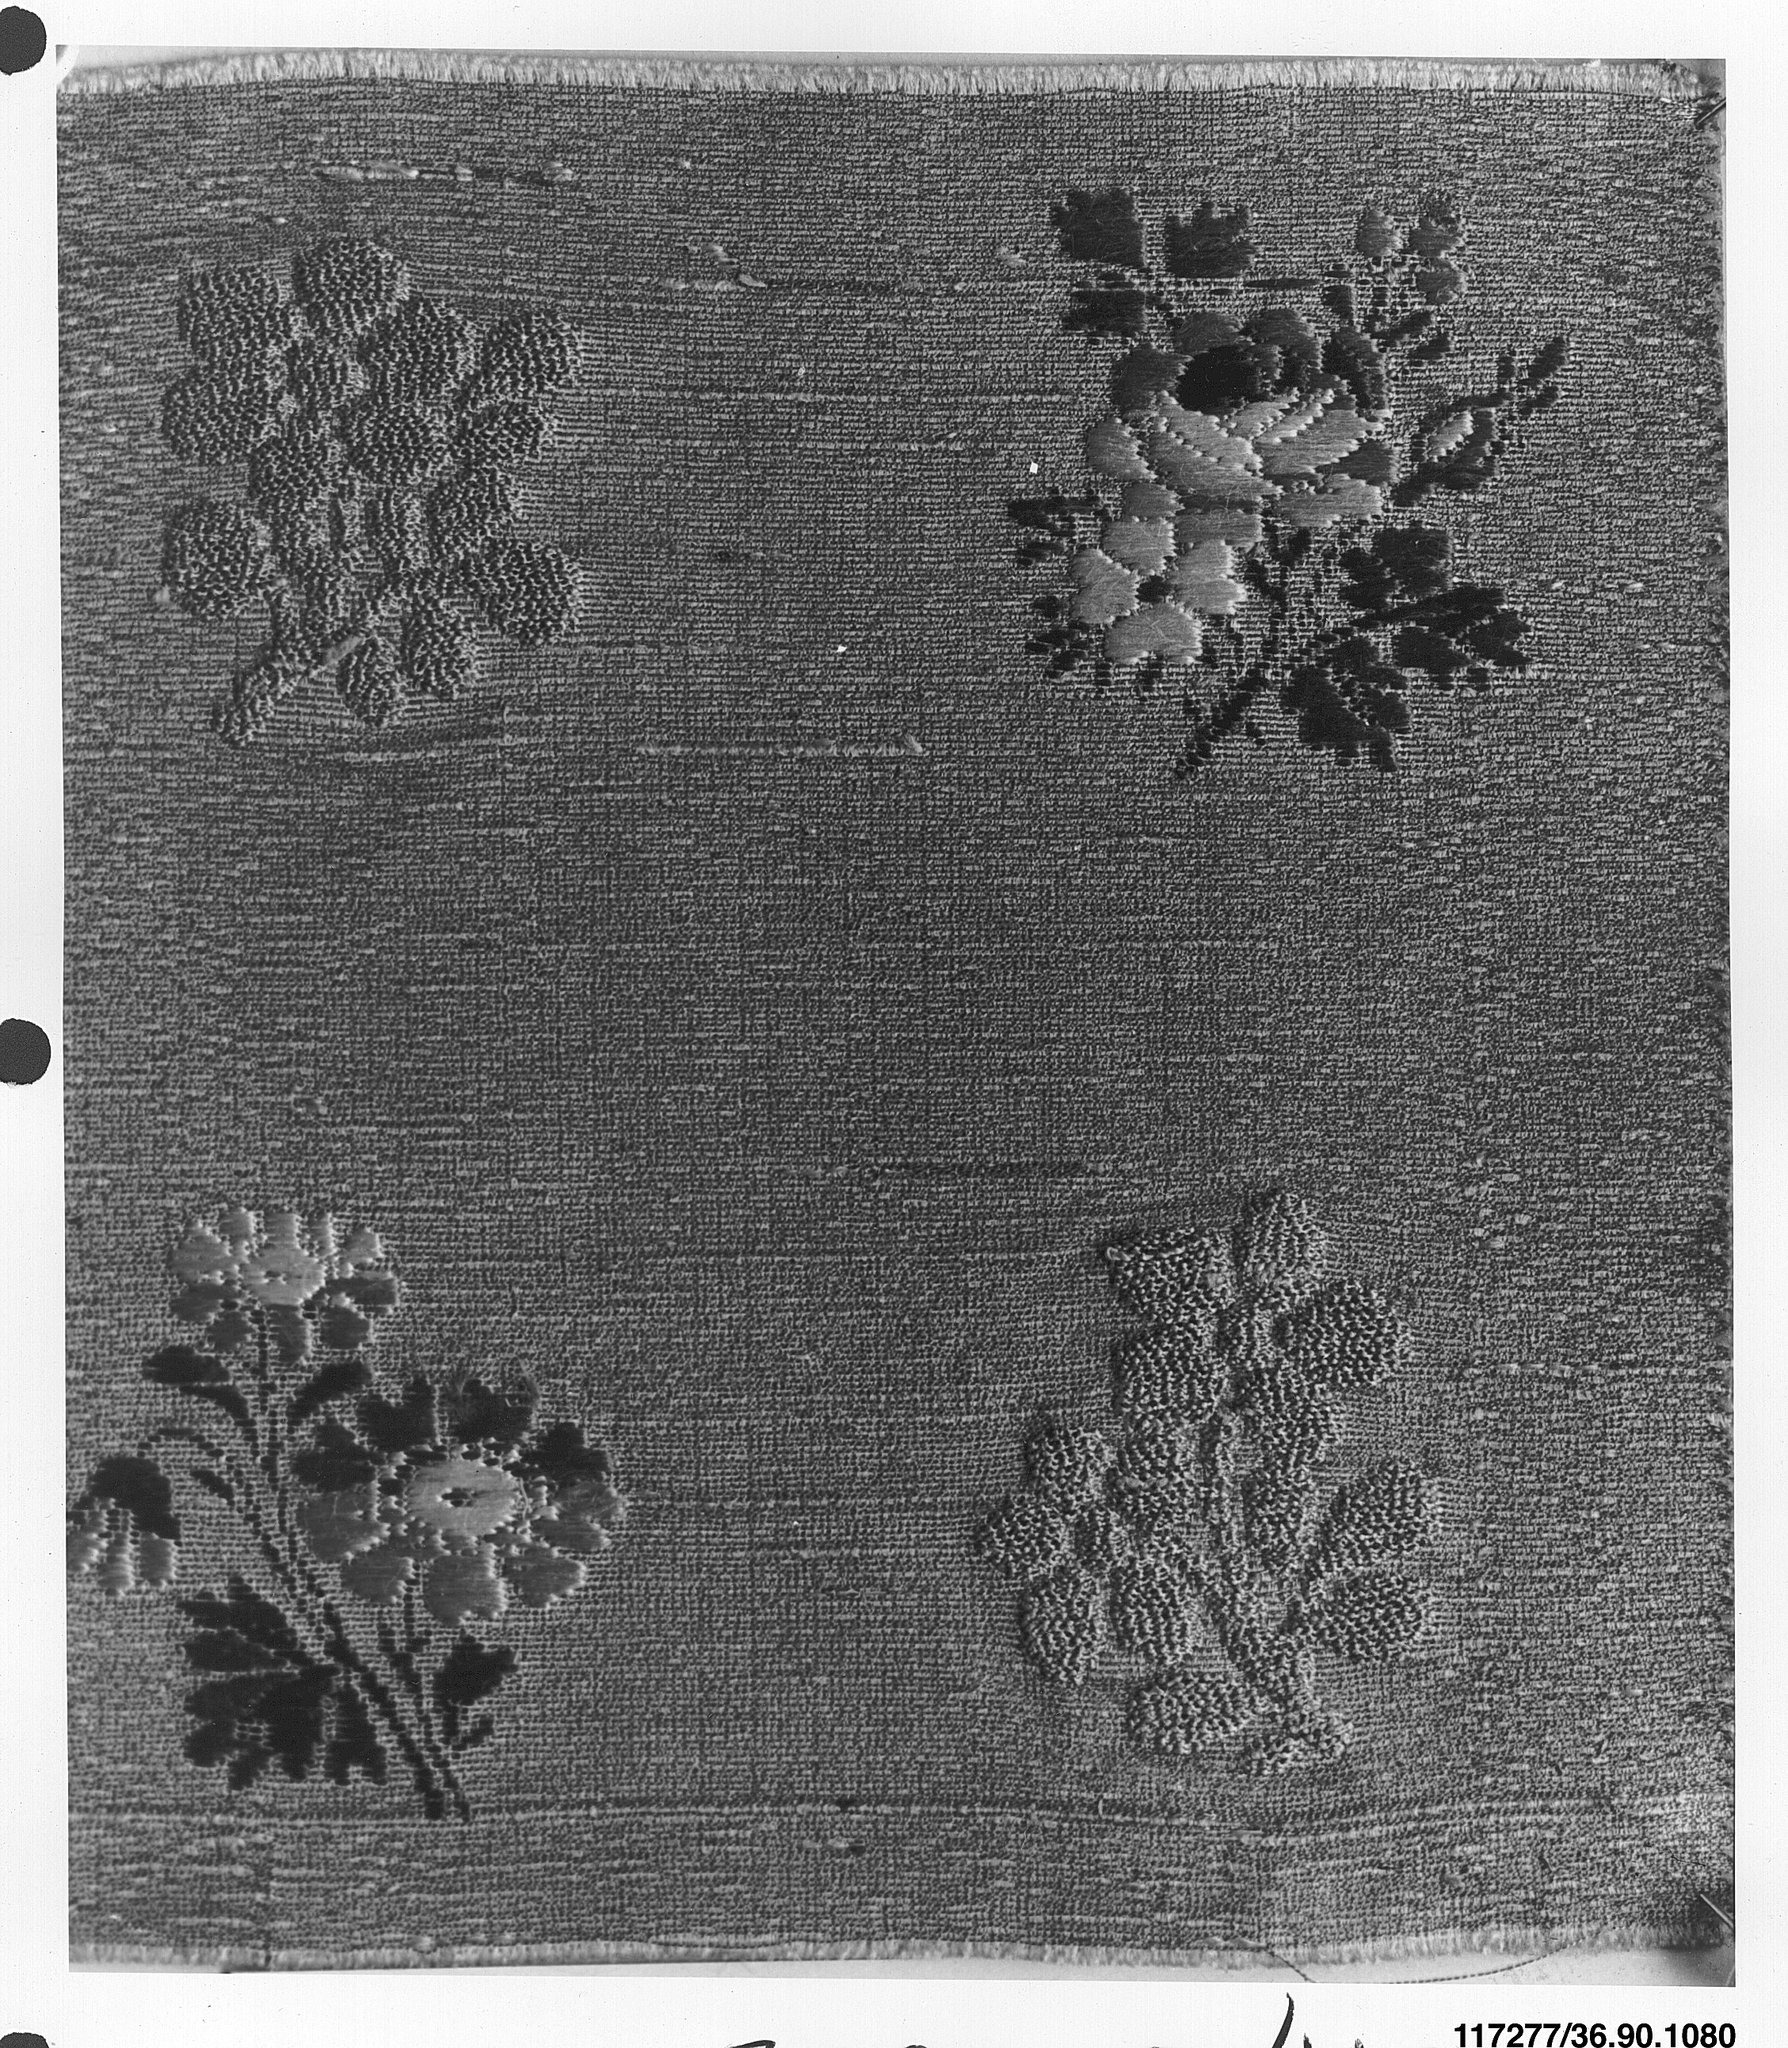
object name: piece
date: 1701-1900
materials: metal thread, silk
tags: flowers,leaves